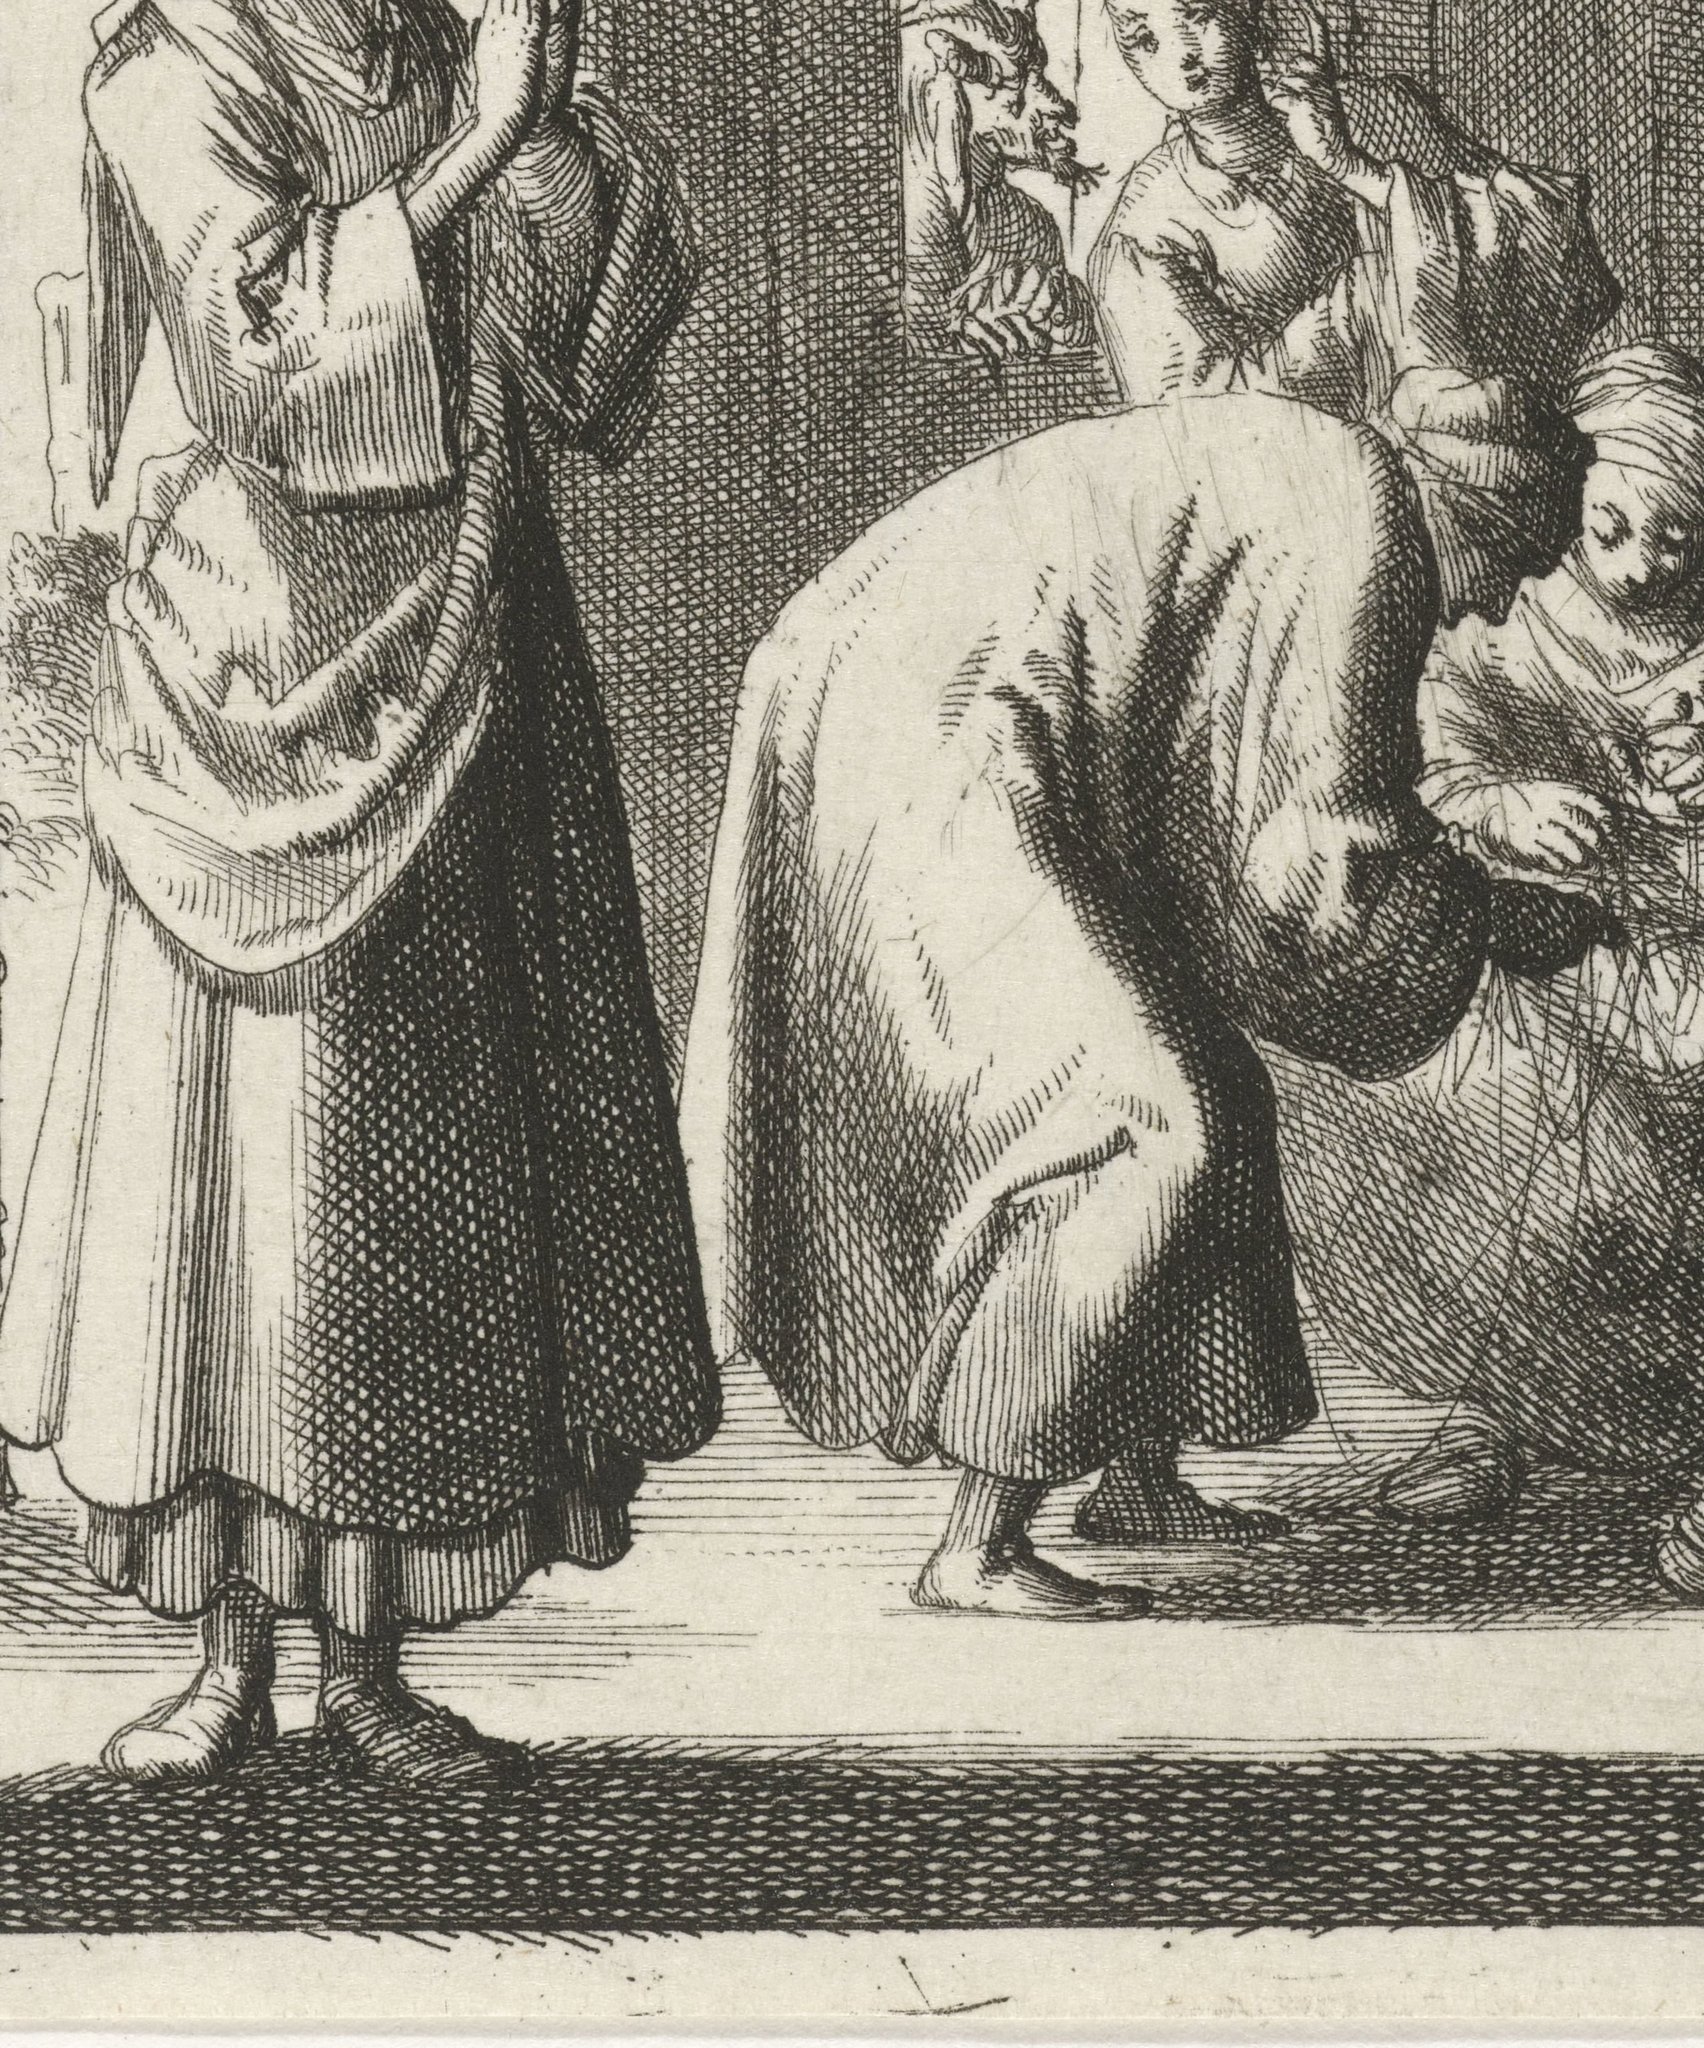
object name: book illustration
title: De quaa, Is naa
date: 1687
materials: paper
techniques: etching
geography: amsterdam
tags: spinning-wheel, devil(s) and demons: satan, one person praying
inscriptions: collector's mark: Lugt 2228, number: ‘46’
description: Illustratie uit: Luyken, Jan. Voncken der liefde Jesu, van het godtbegerende zielenvier. Amsterdam: Pieter Arentsz (II), 1687, p. 194.